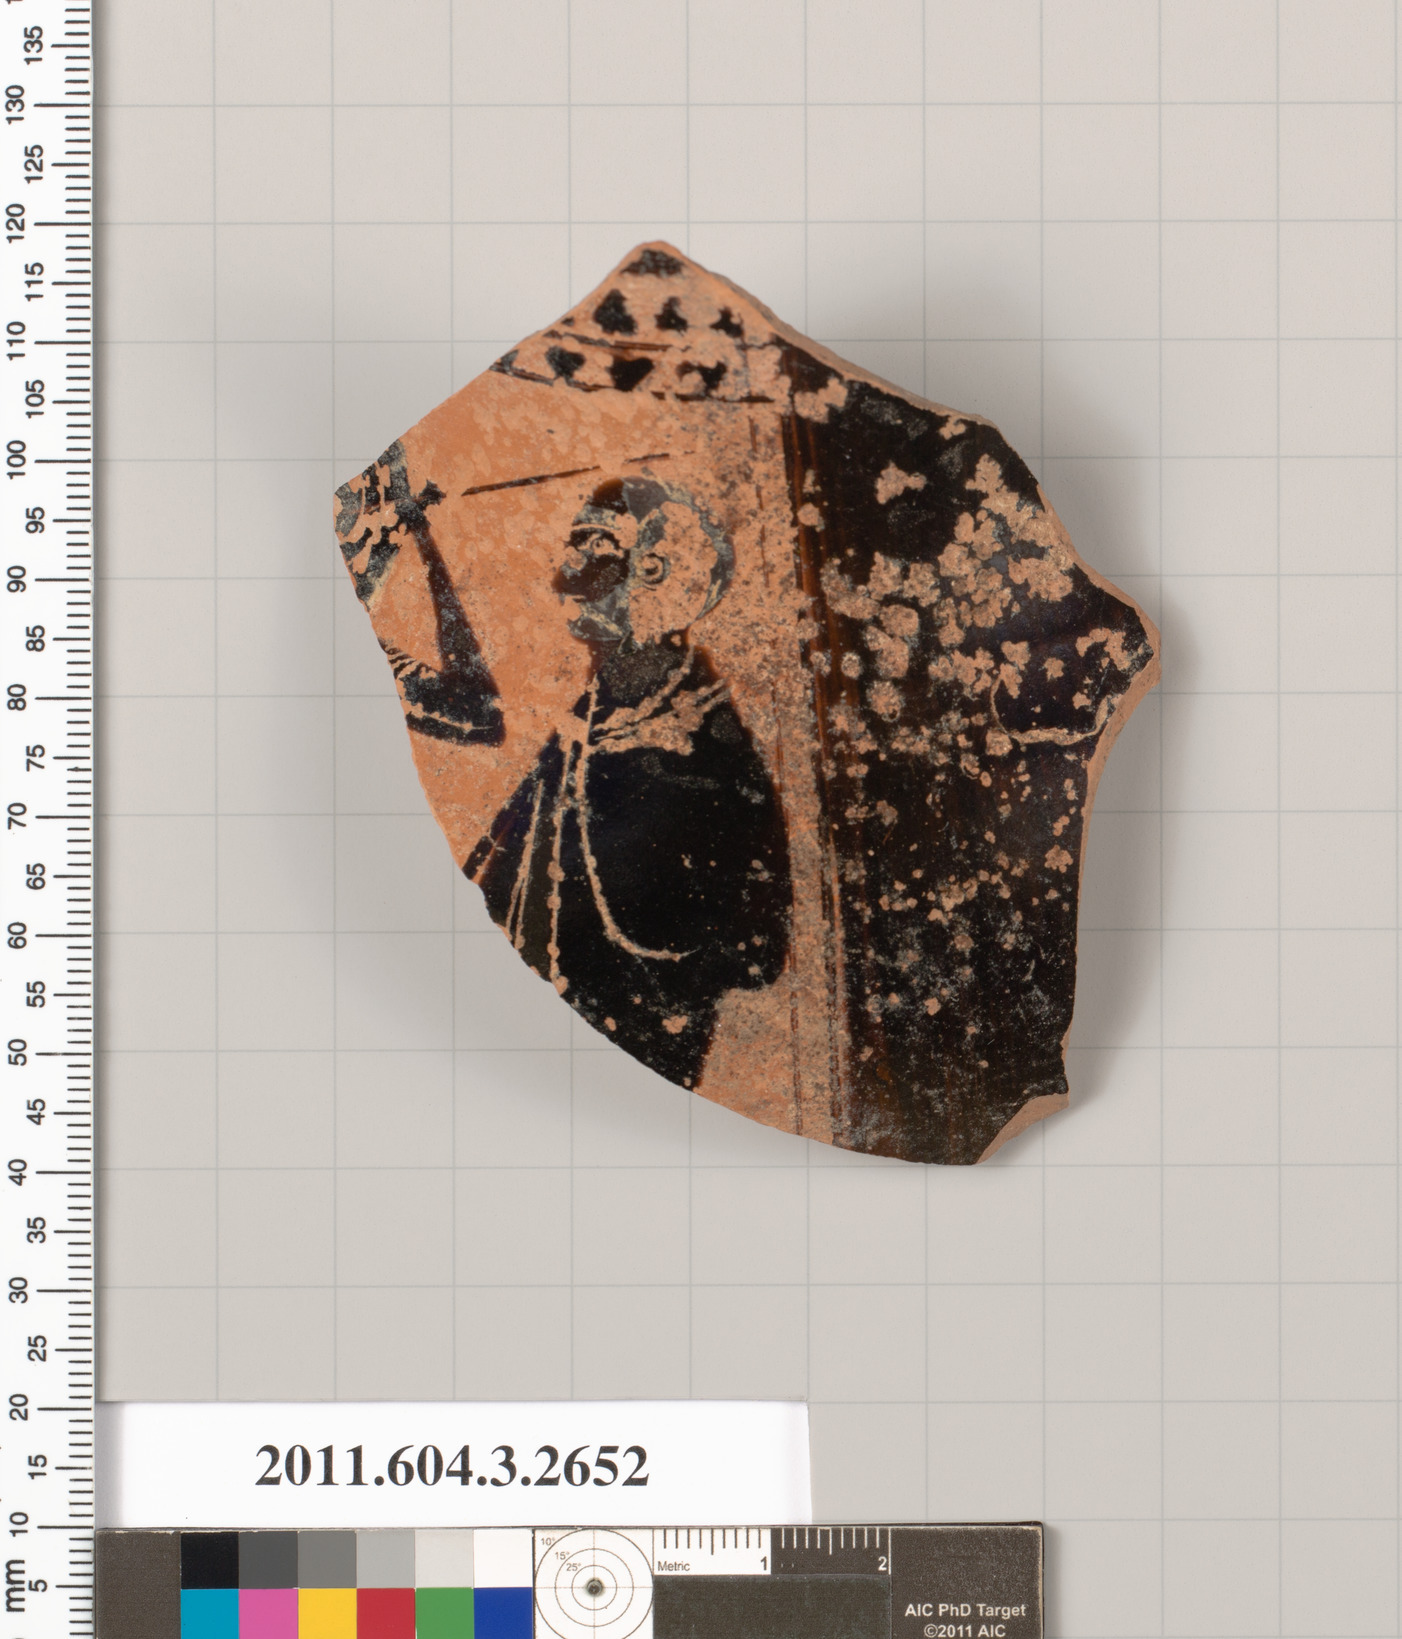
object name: olpe fragment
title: Terracotta fragment of an olpe (jug)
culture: greek, attic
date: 530-520 BCE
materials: terracotta